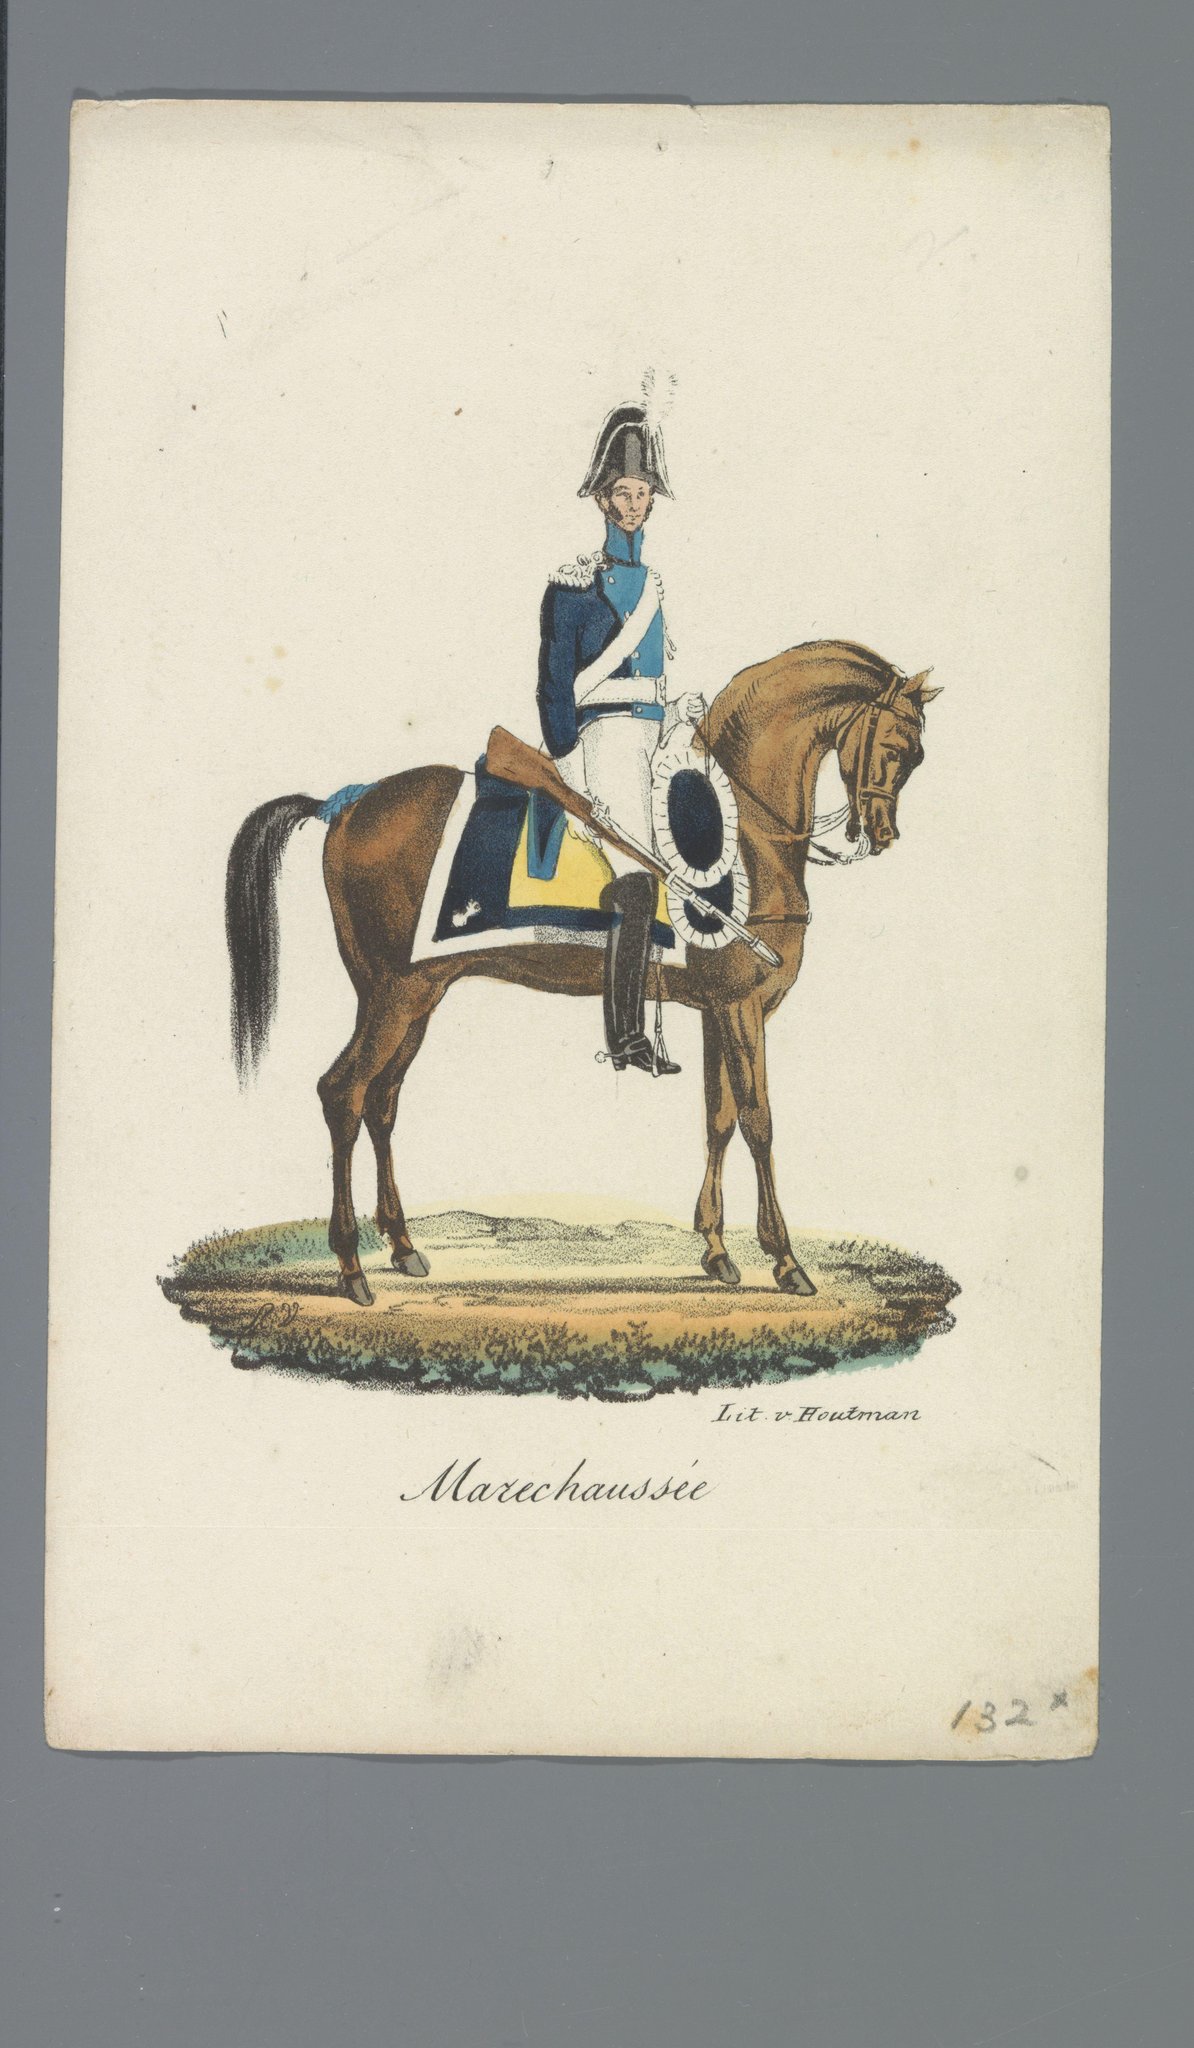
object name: costume print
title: Marechaussée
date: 1835-1850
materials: paper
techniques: hand coloring, lithograph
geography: utrecht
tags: (military) uniforms, clothes, costume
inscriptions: collector's mark: Lugt 2228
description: Een marechaussee, te paard. Onderdeel van een serie van 157 losse bladen met Nederlandse militaire uniformen in de jaren 1830-1832.